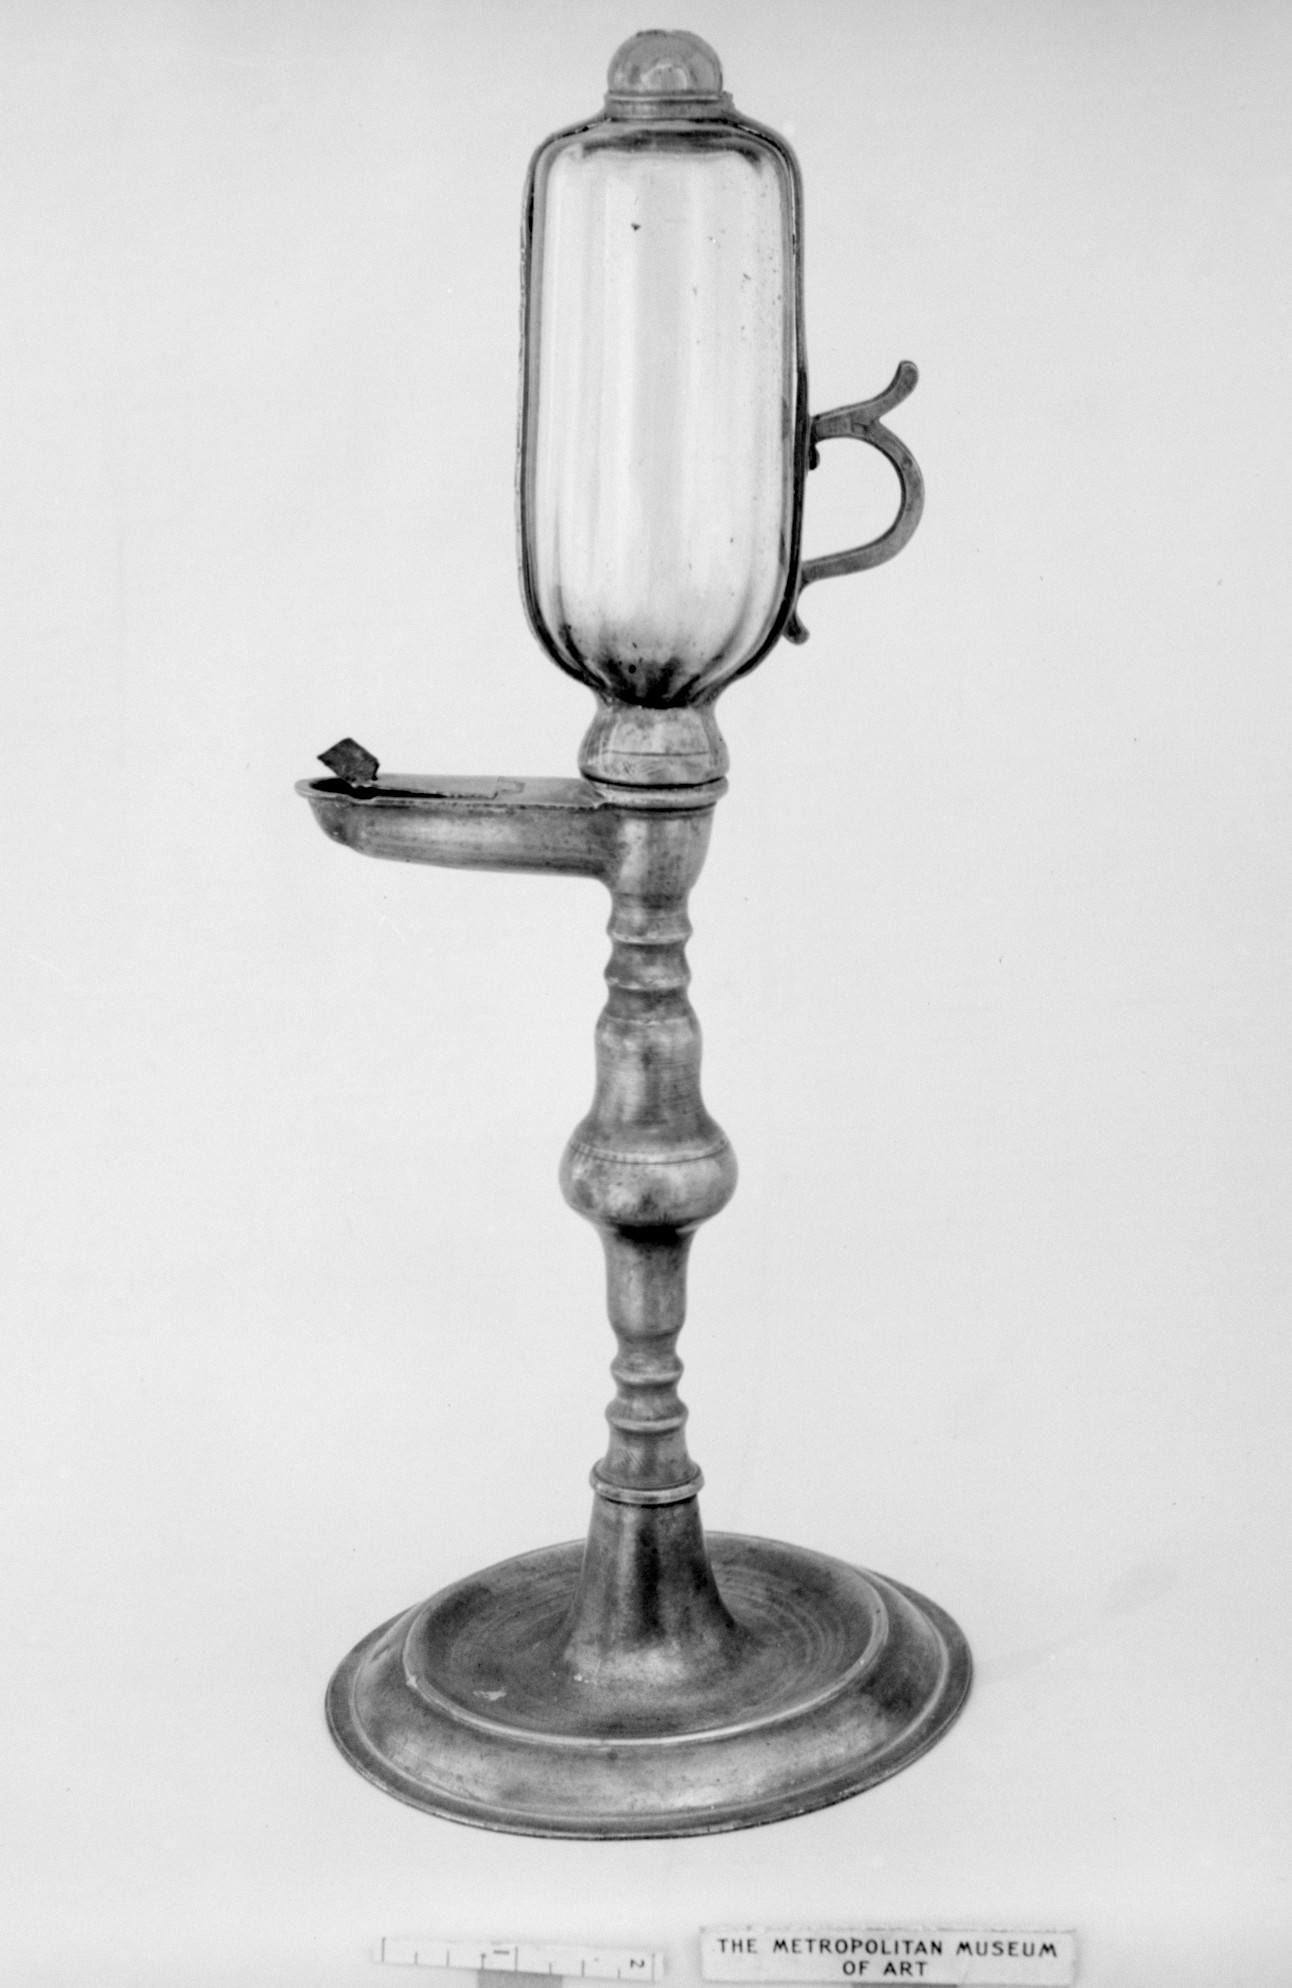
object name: clock lamp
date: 1601-1800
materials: glass, pewter